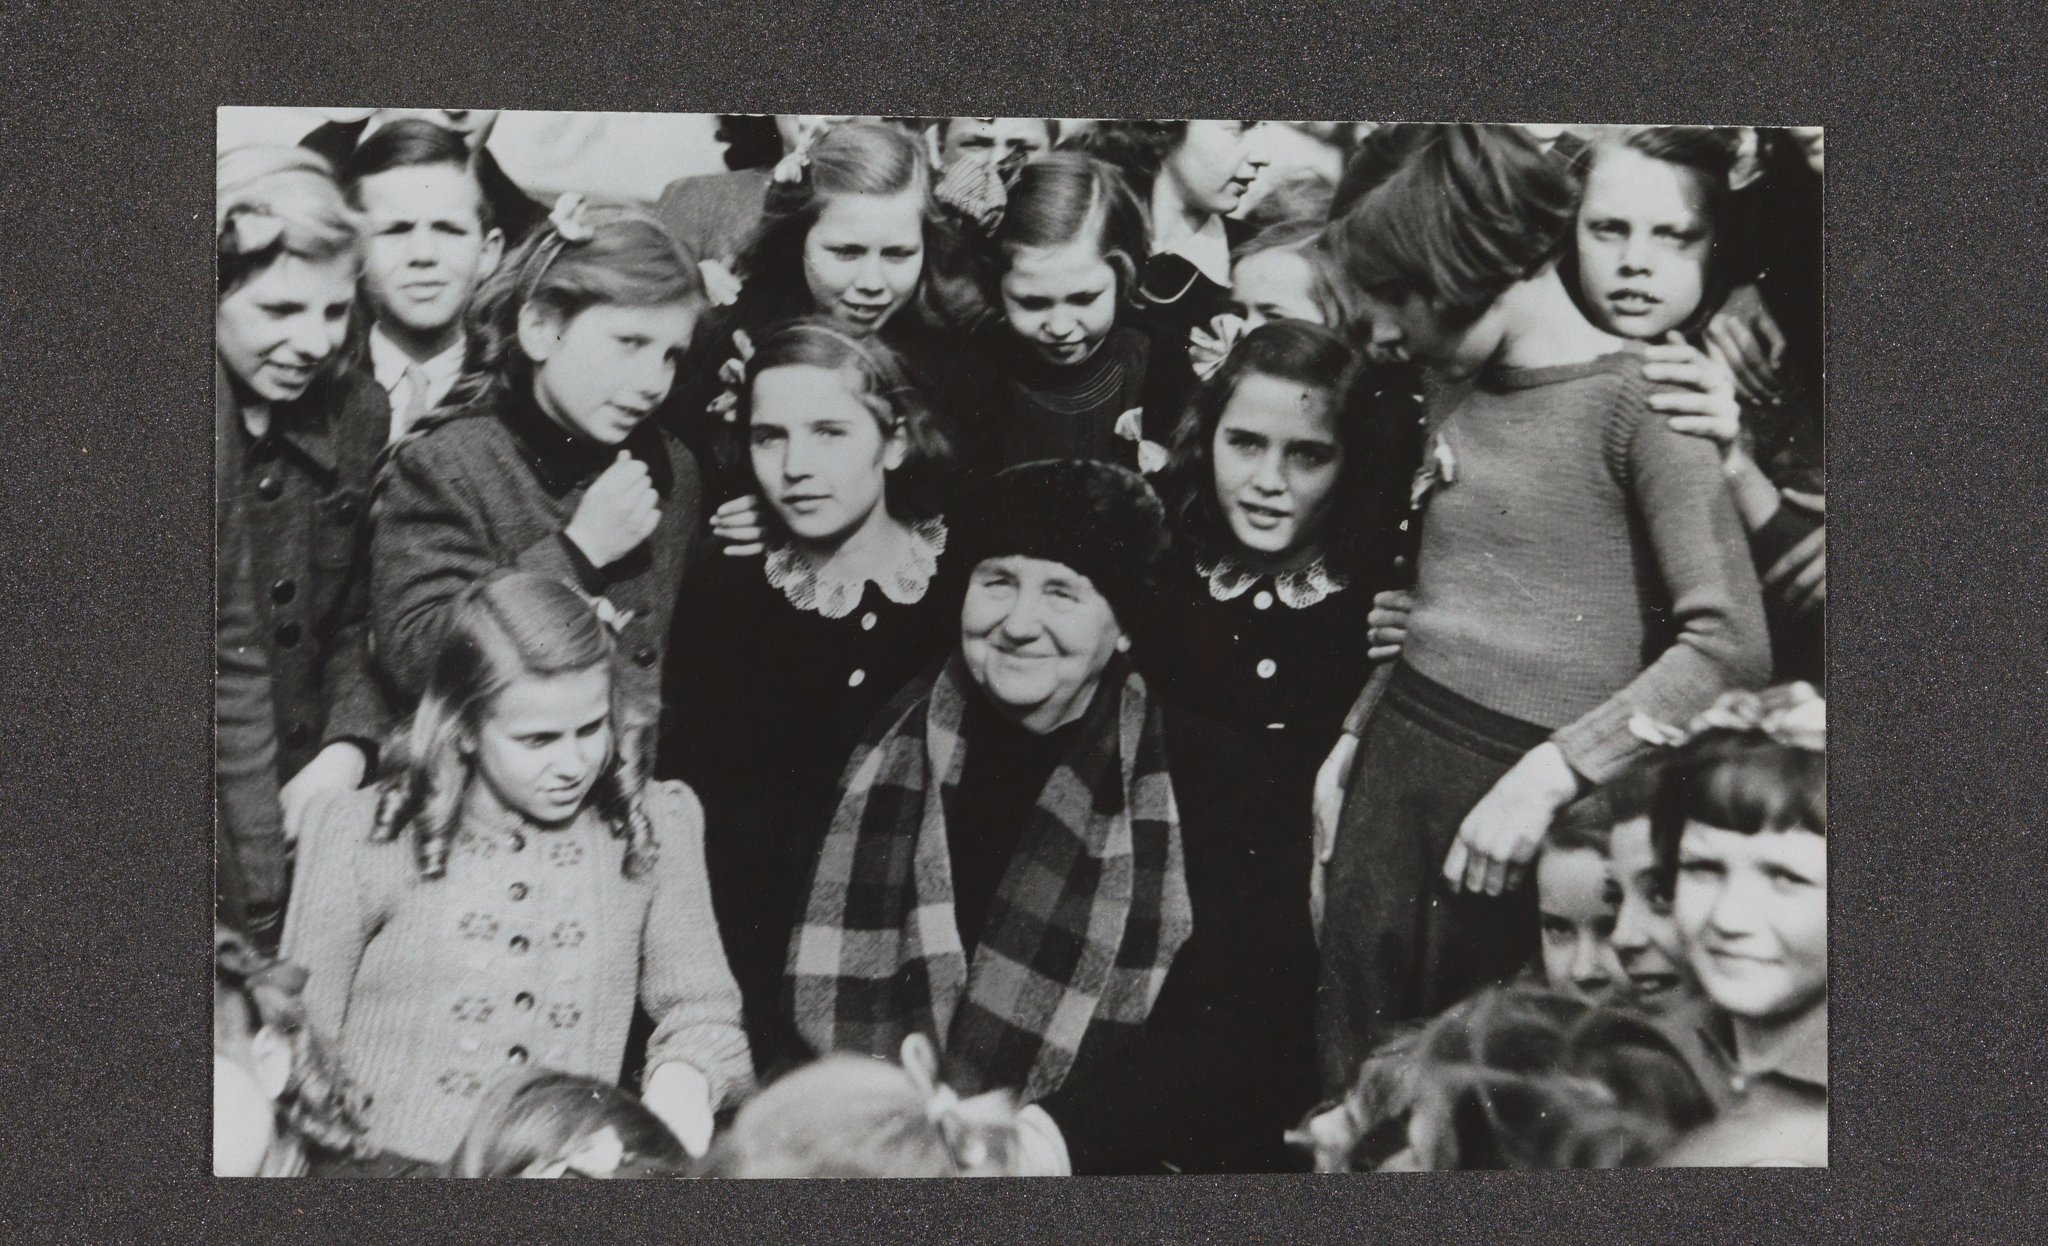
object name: photograph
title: Portret van Koningin Wilhelmina temidden van een groep kinderen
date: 1940-1950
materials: photographic support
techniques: gelatin silver print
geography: amsterdam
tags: the hague, print maker, wilhelmina of the netherlands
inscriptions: inscription: ‘Kind voor haar uit ... [onleesbaar]’